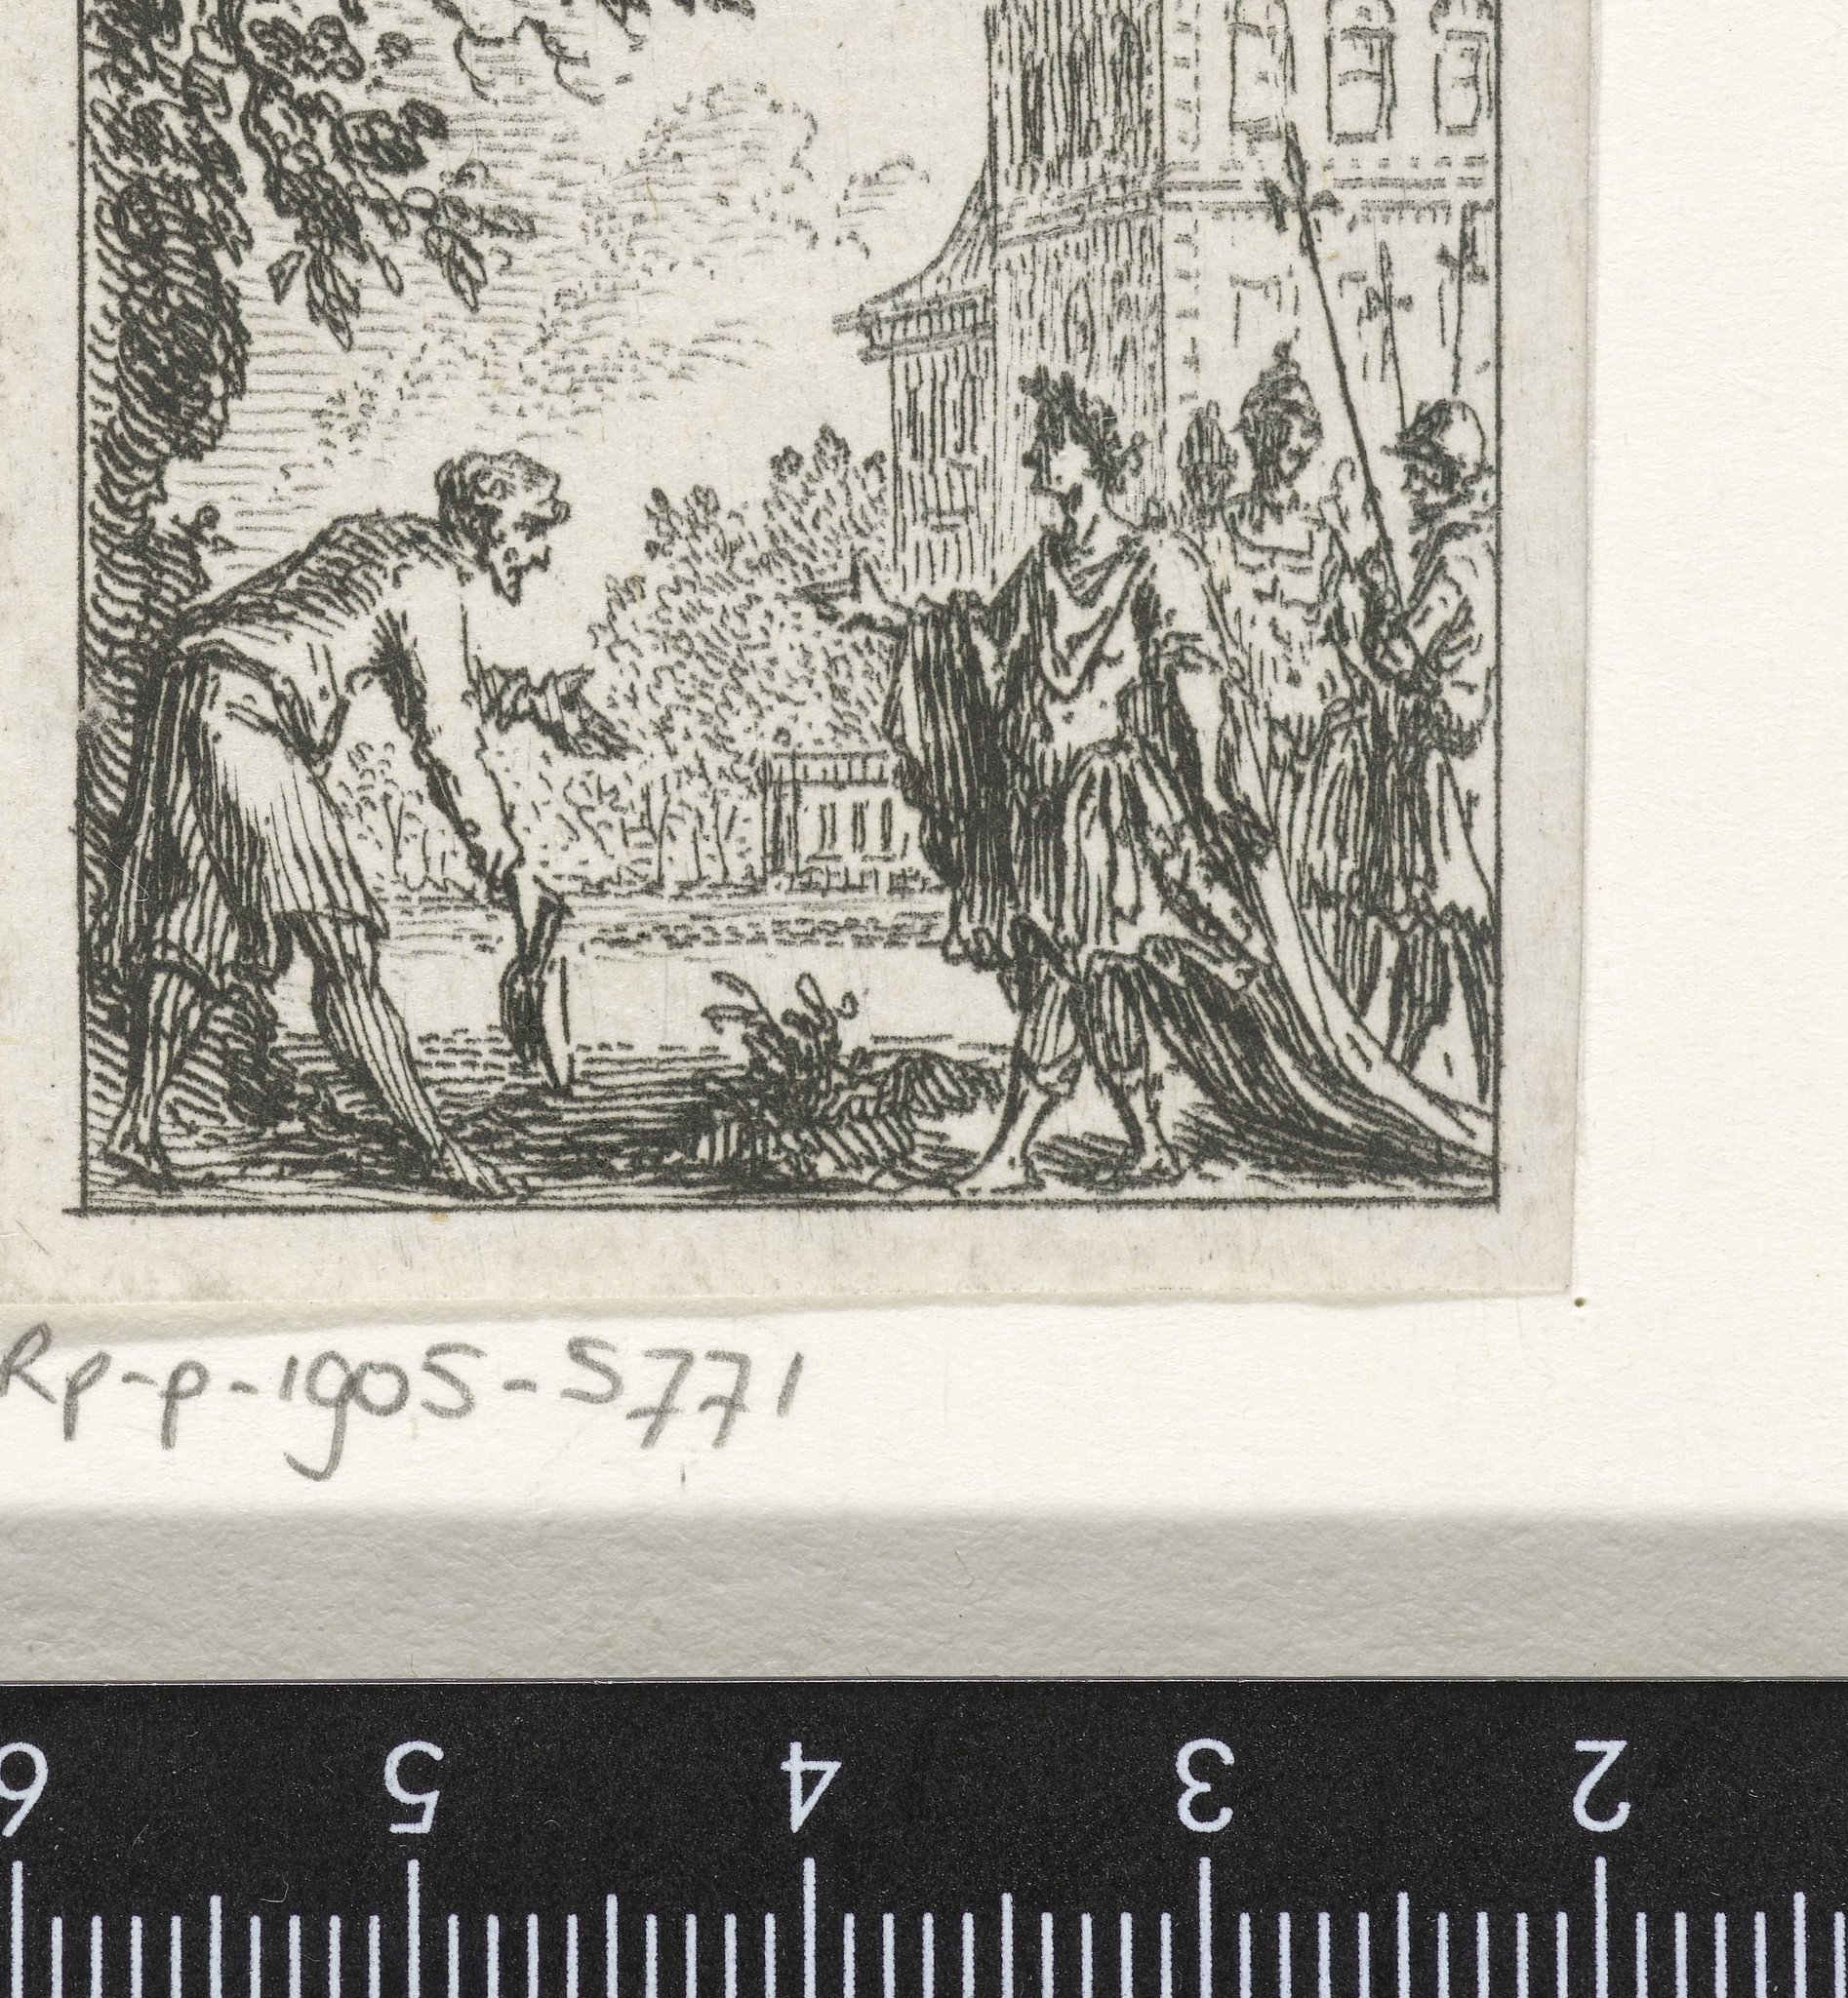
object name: book illustration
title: Illustraties voor fabelvertellingen van Phaedrus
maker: simon fokke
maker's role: draughtsman, print maker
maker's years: 1712-1784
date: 1769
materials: paper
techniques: etching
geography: amsterdam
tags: fables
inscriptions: collector's mark: Lugt 2228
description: Een dienaar heeft zijn hoed afgenomen om te buigen voor de keizer die tot hem spreekt. Deze illustratie is vervaardigd bij de Aesopische fabels van de Latijnse dichter Phaedrus.